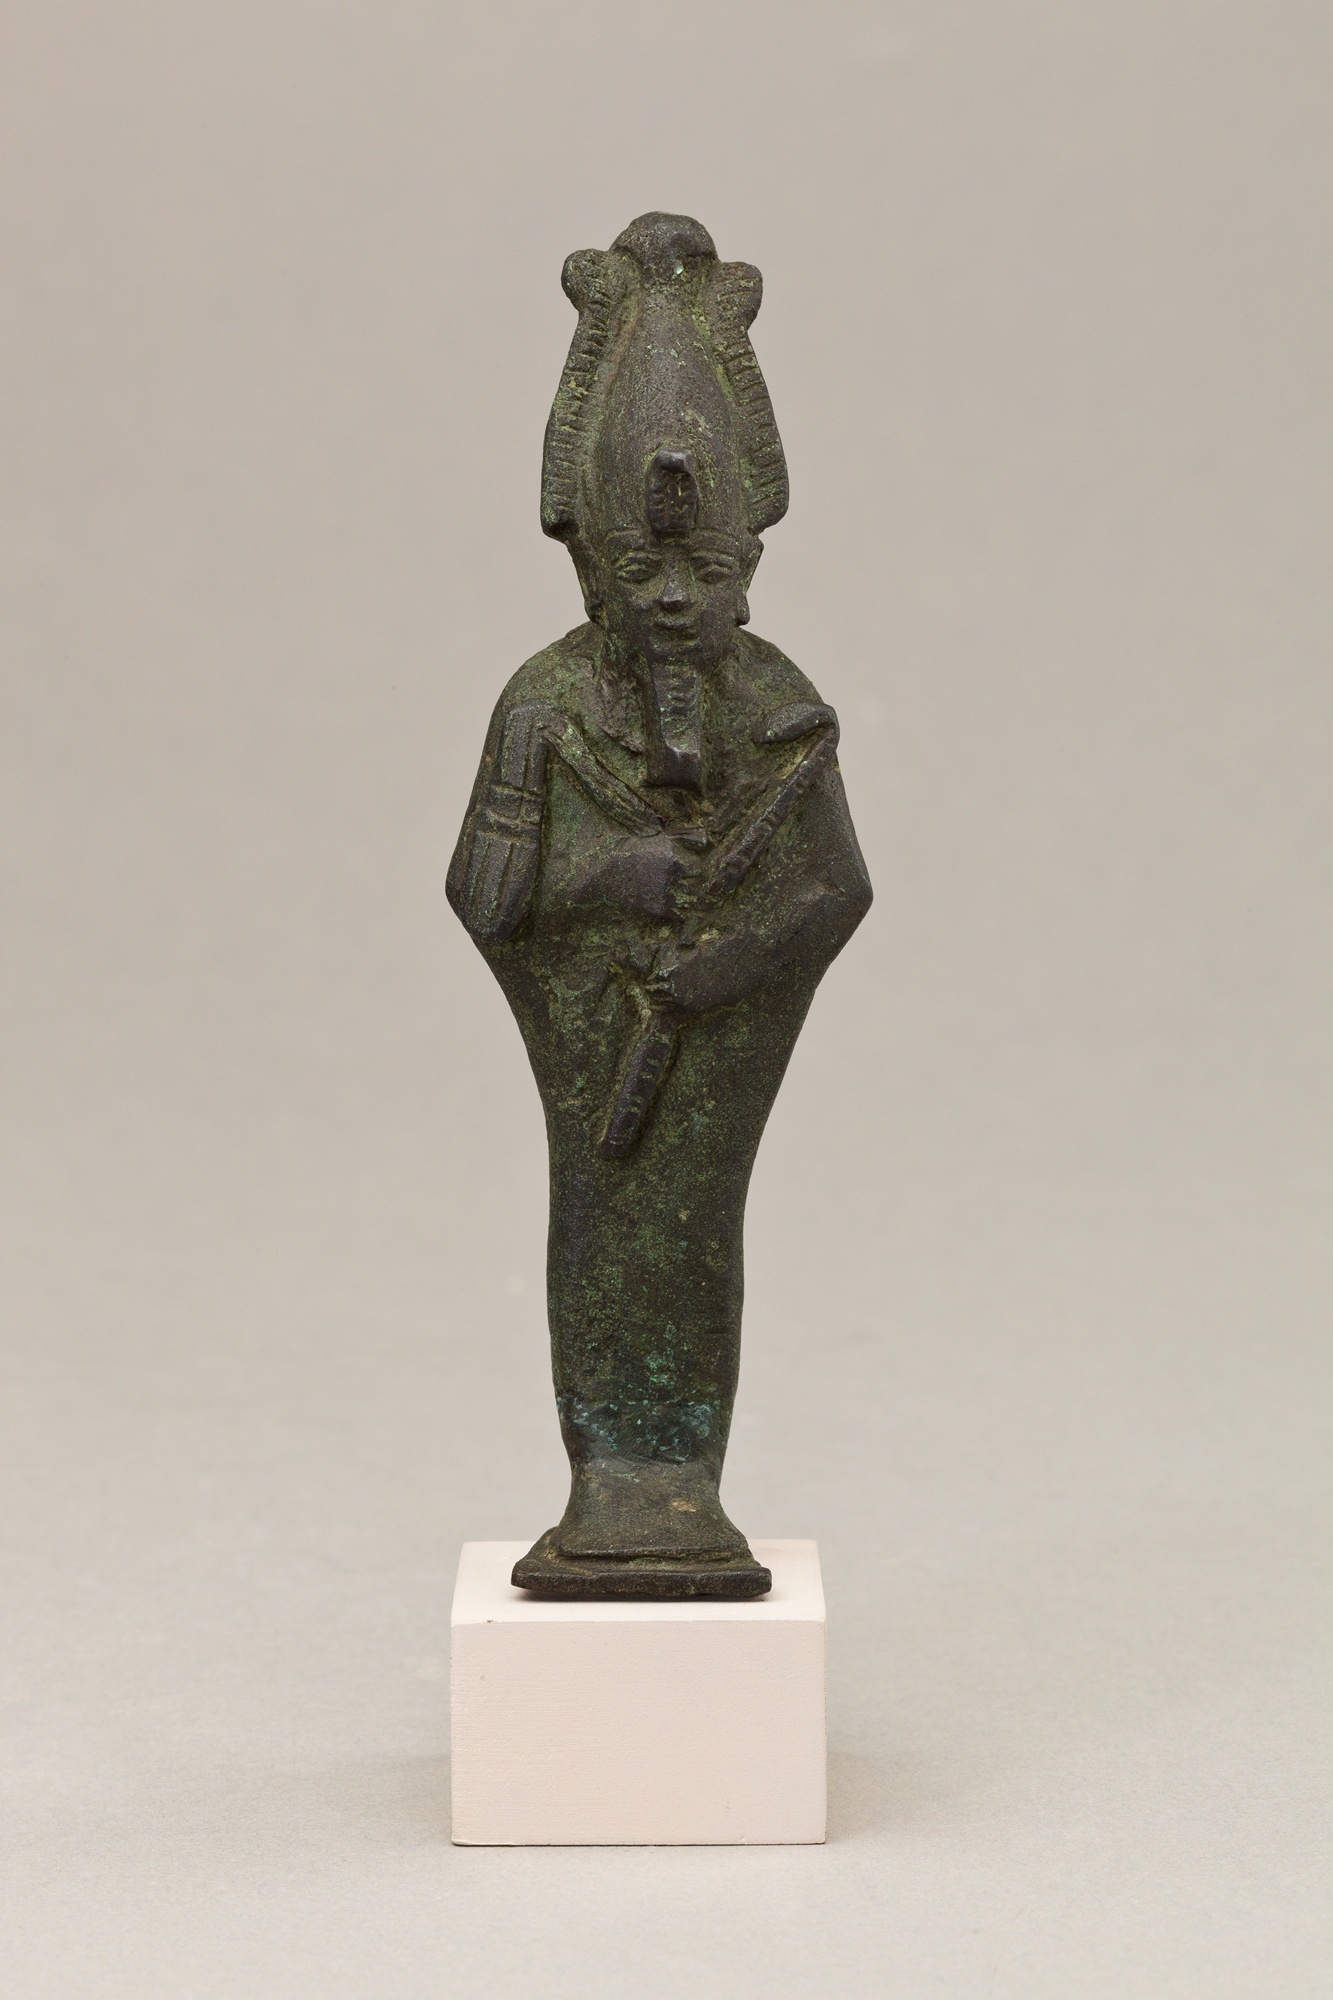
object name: statuette, osiris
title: Osiris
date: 664-630 BCE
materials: metal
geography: egypt